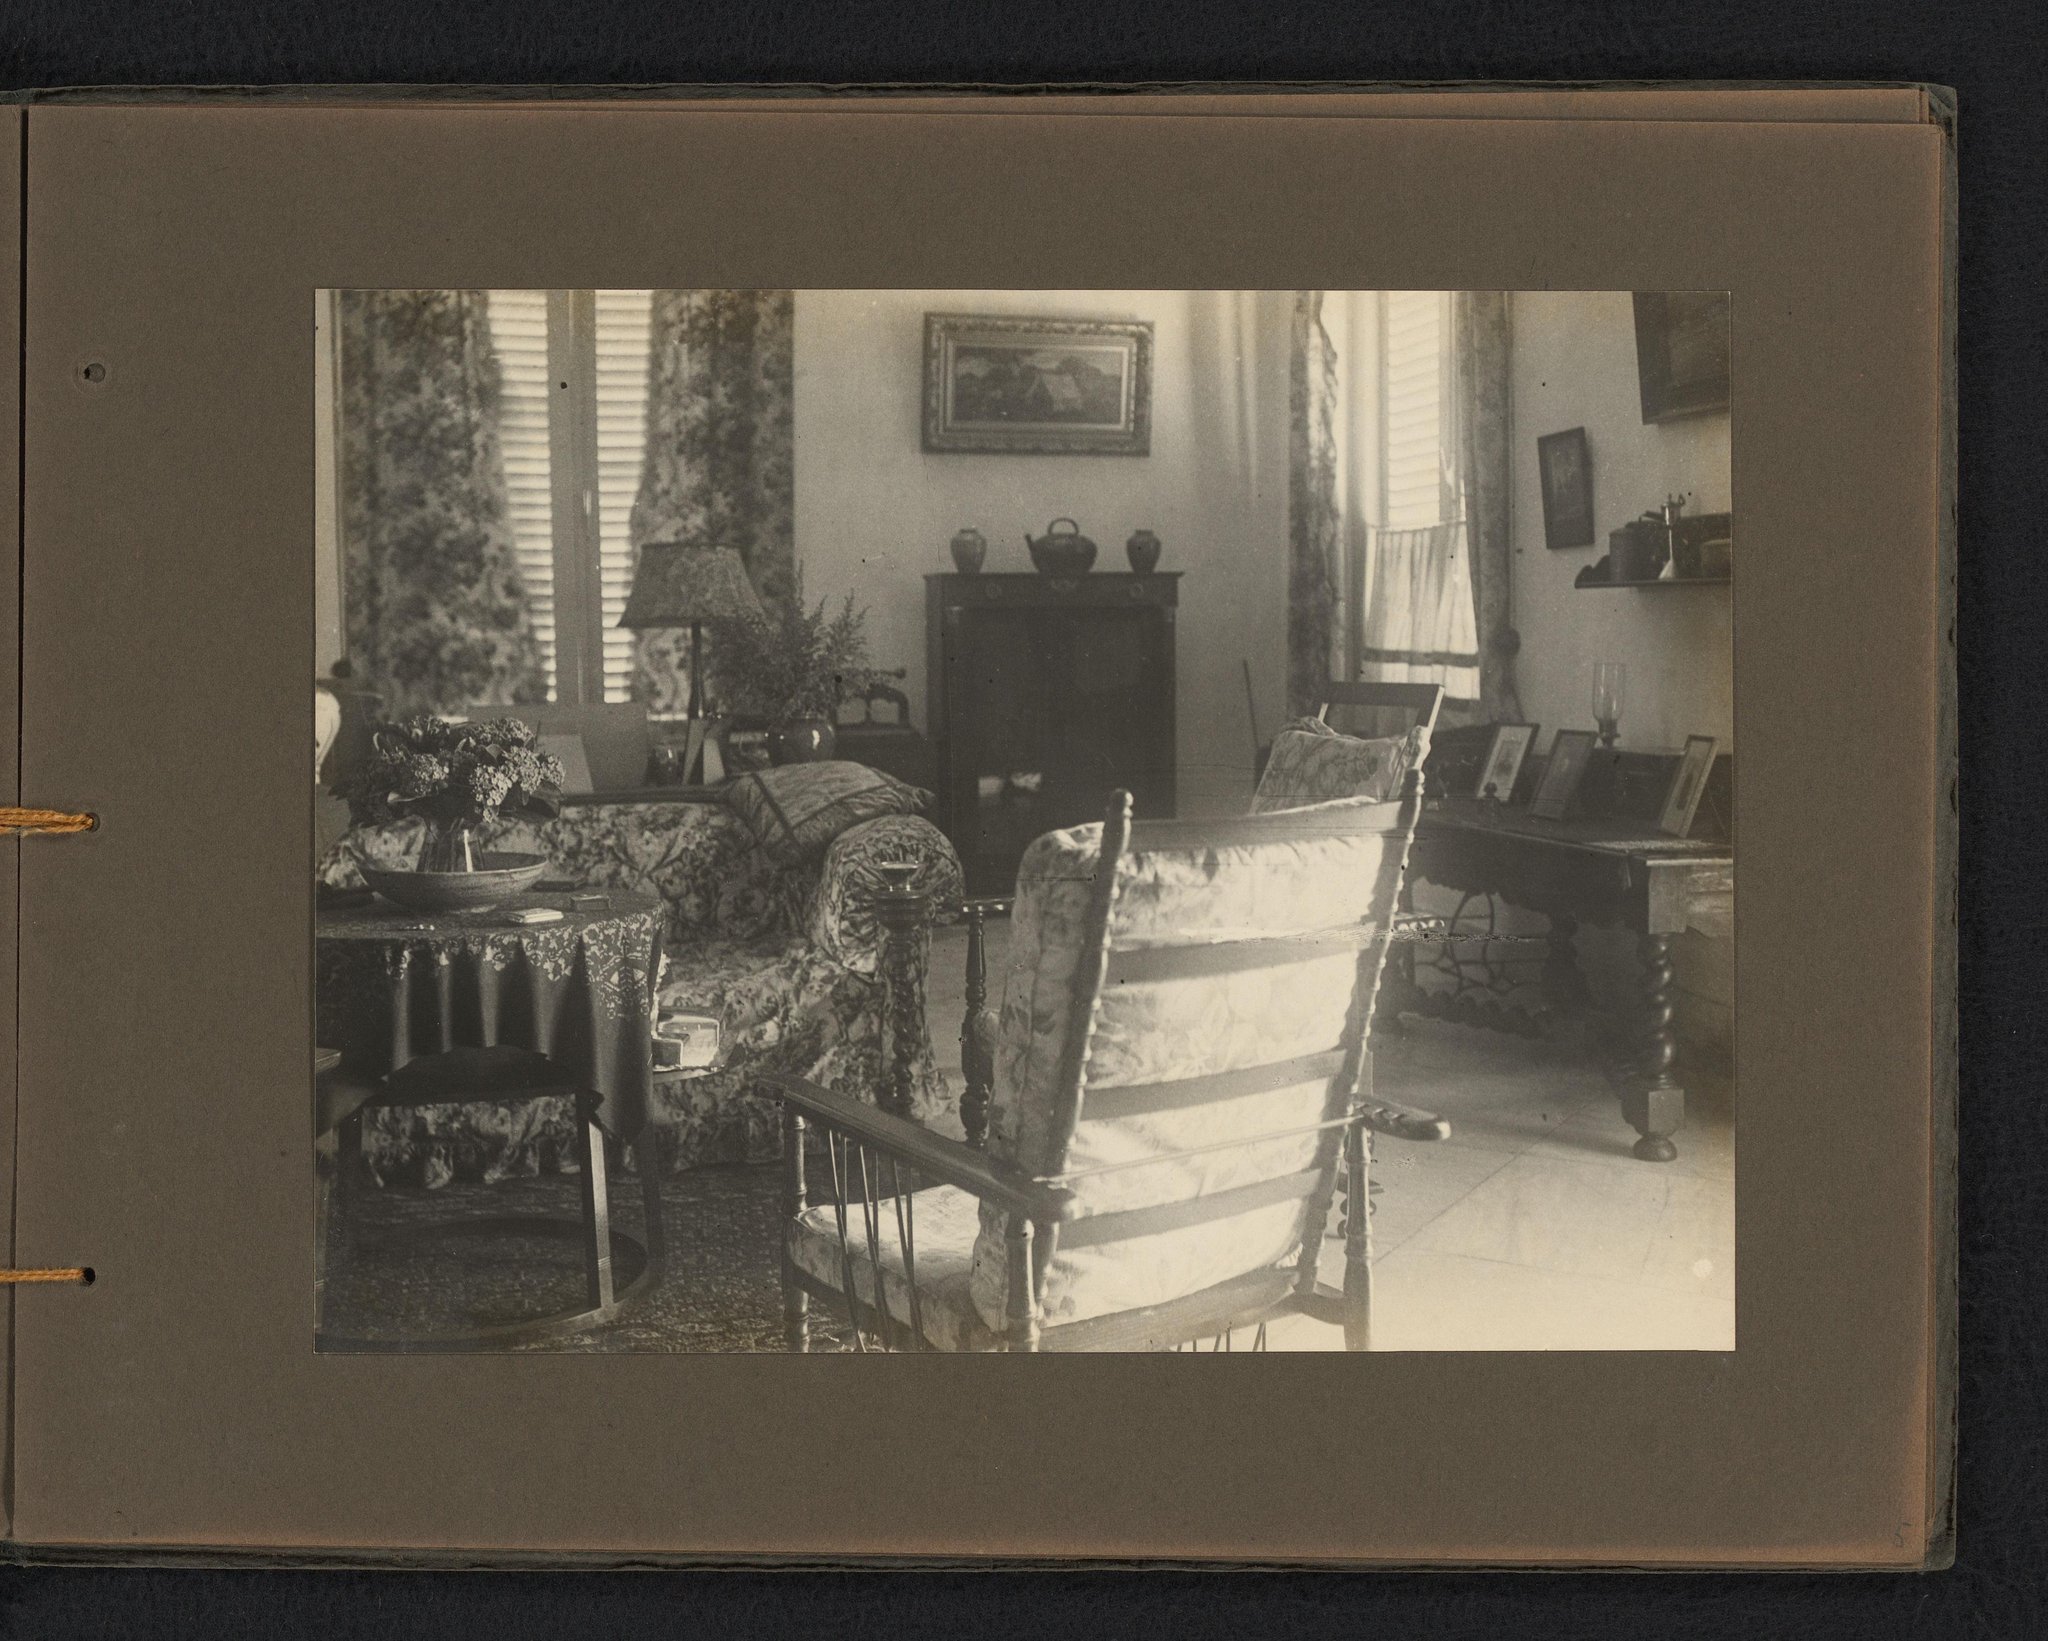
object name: photograph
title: Interieur van een werkkamer in de ambtswoning van de Javasche Bank te Batavia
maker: Anonymous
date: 1921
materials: paper, cardboard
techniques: gelatin silver print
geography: batavia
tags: interior ~ representation of a building, living-room, parlour, sitting-room, batavia